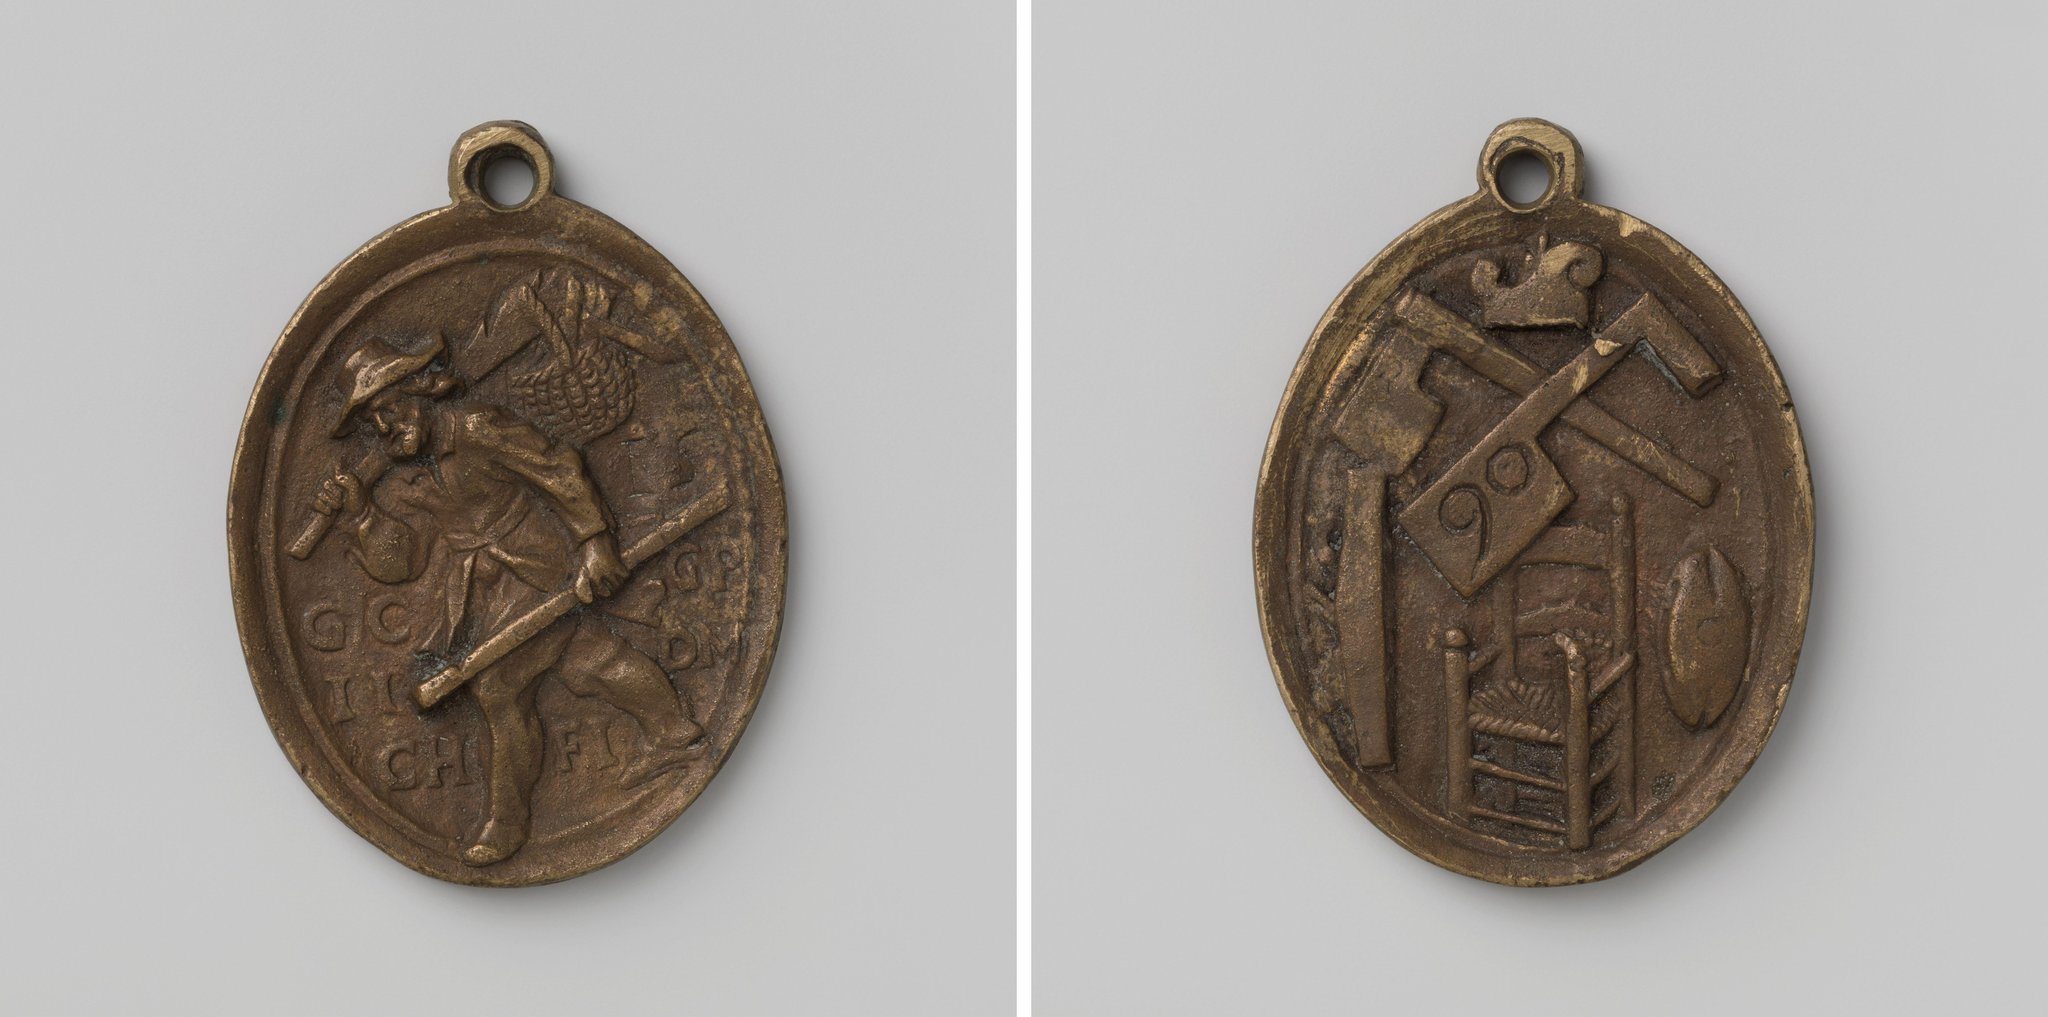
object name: medal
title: Timmerliedengilde van Rotterdam, gildepenning met no. 15 en no. 90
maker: Anonymous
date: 1600-1700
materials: brass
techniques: casting, engraving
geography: rotterdam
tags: rotterdam